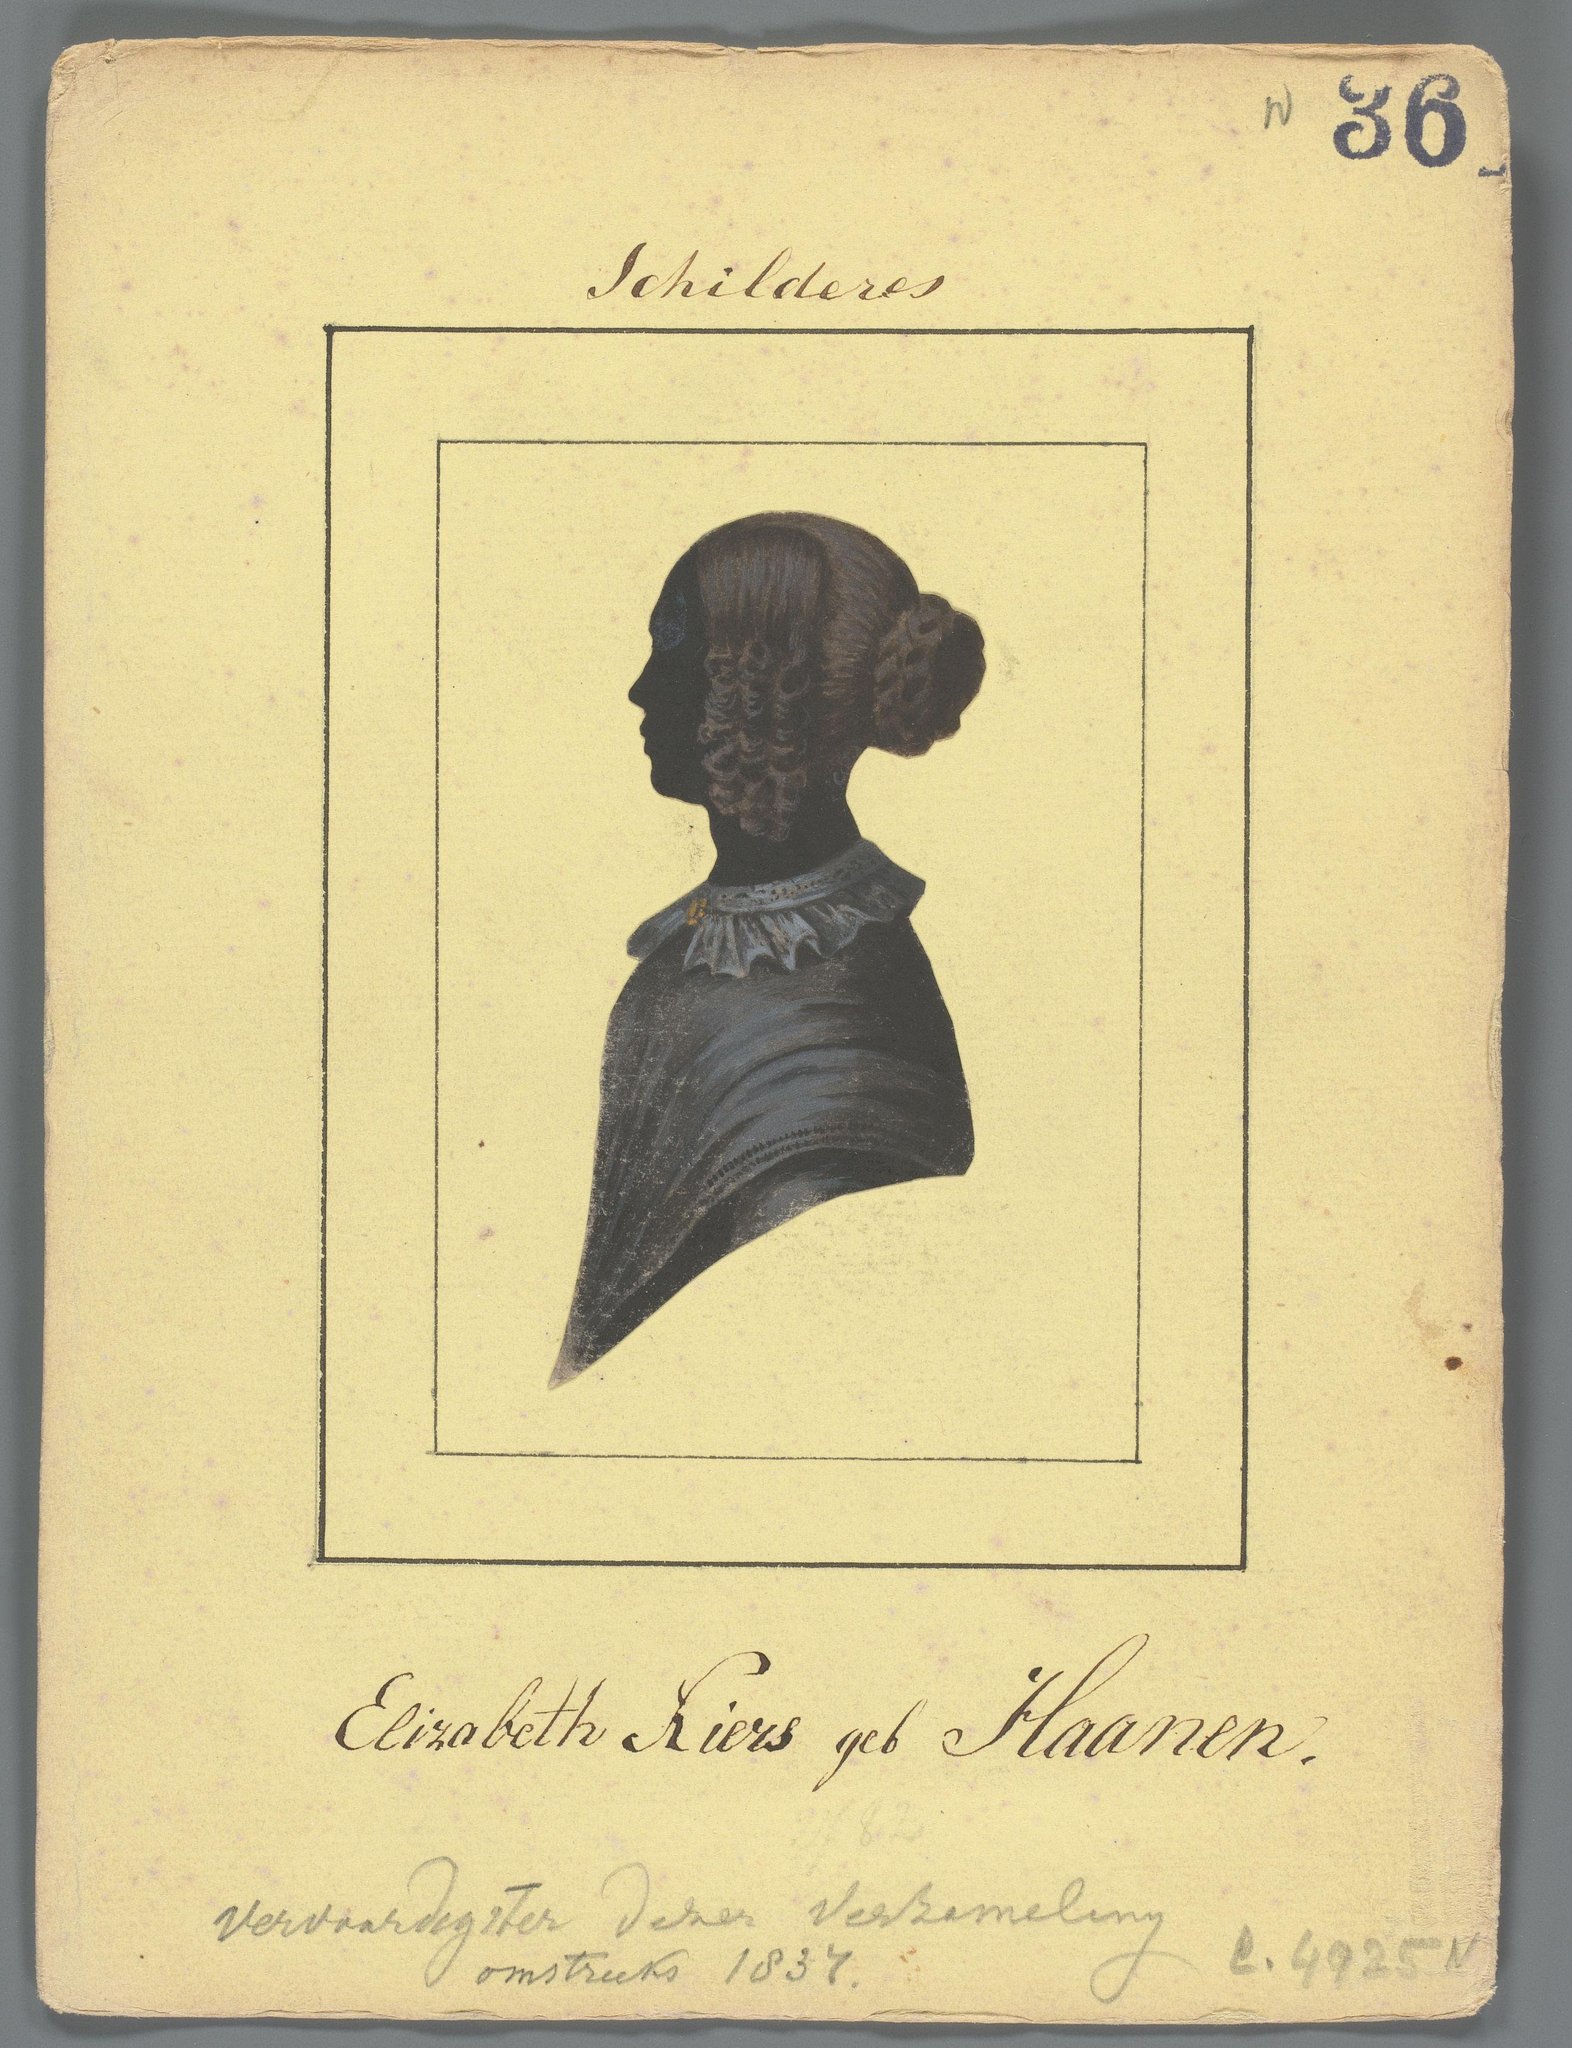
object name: silhouette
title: Zelfportret in silhouet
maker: elisabeth alida haanen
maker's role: draughtsman, print maker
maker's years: 1809-1845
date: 1819-1845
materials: ink, paint, paper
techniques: brush, snipping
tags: utrecht, amsterdam, print maker, draughtsman, elisabeth alida haanen, historical persons - bb - woman, portrait, self-portrait of painter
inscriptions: collector's mark: ‘Ex-libris van Beresteyn’, inscription: ‘Schilderes’, number: ‘13972’, number: ‘36’, inscription: ‘D. 1340’, inscription: ‘Elizabeth Kiers geb Haanen’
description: Met onder het portret de handtekening van de geportretteerde.